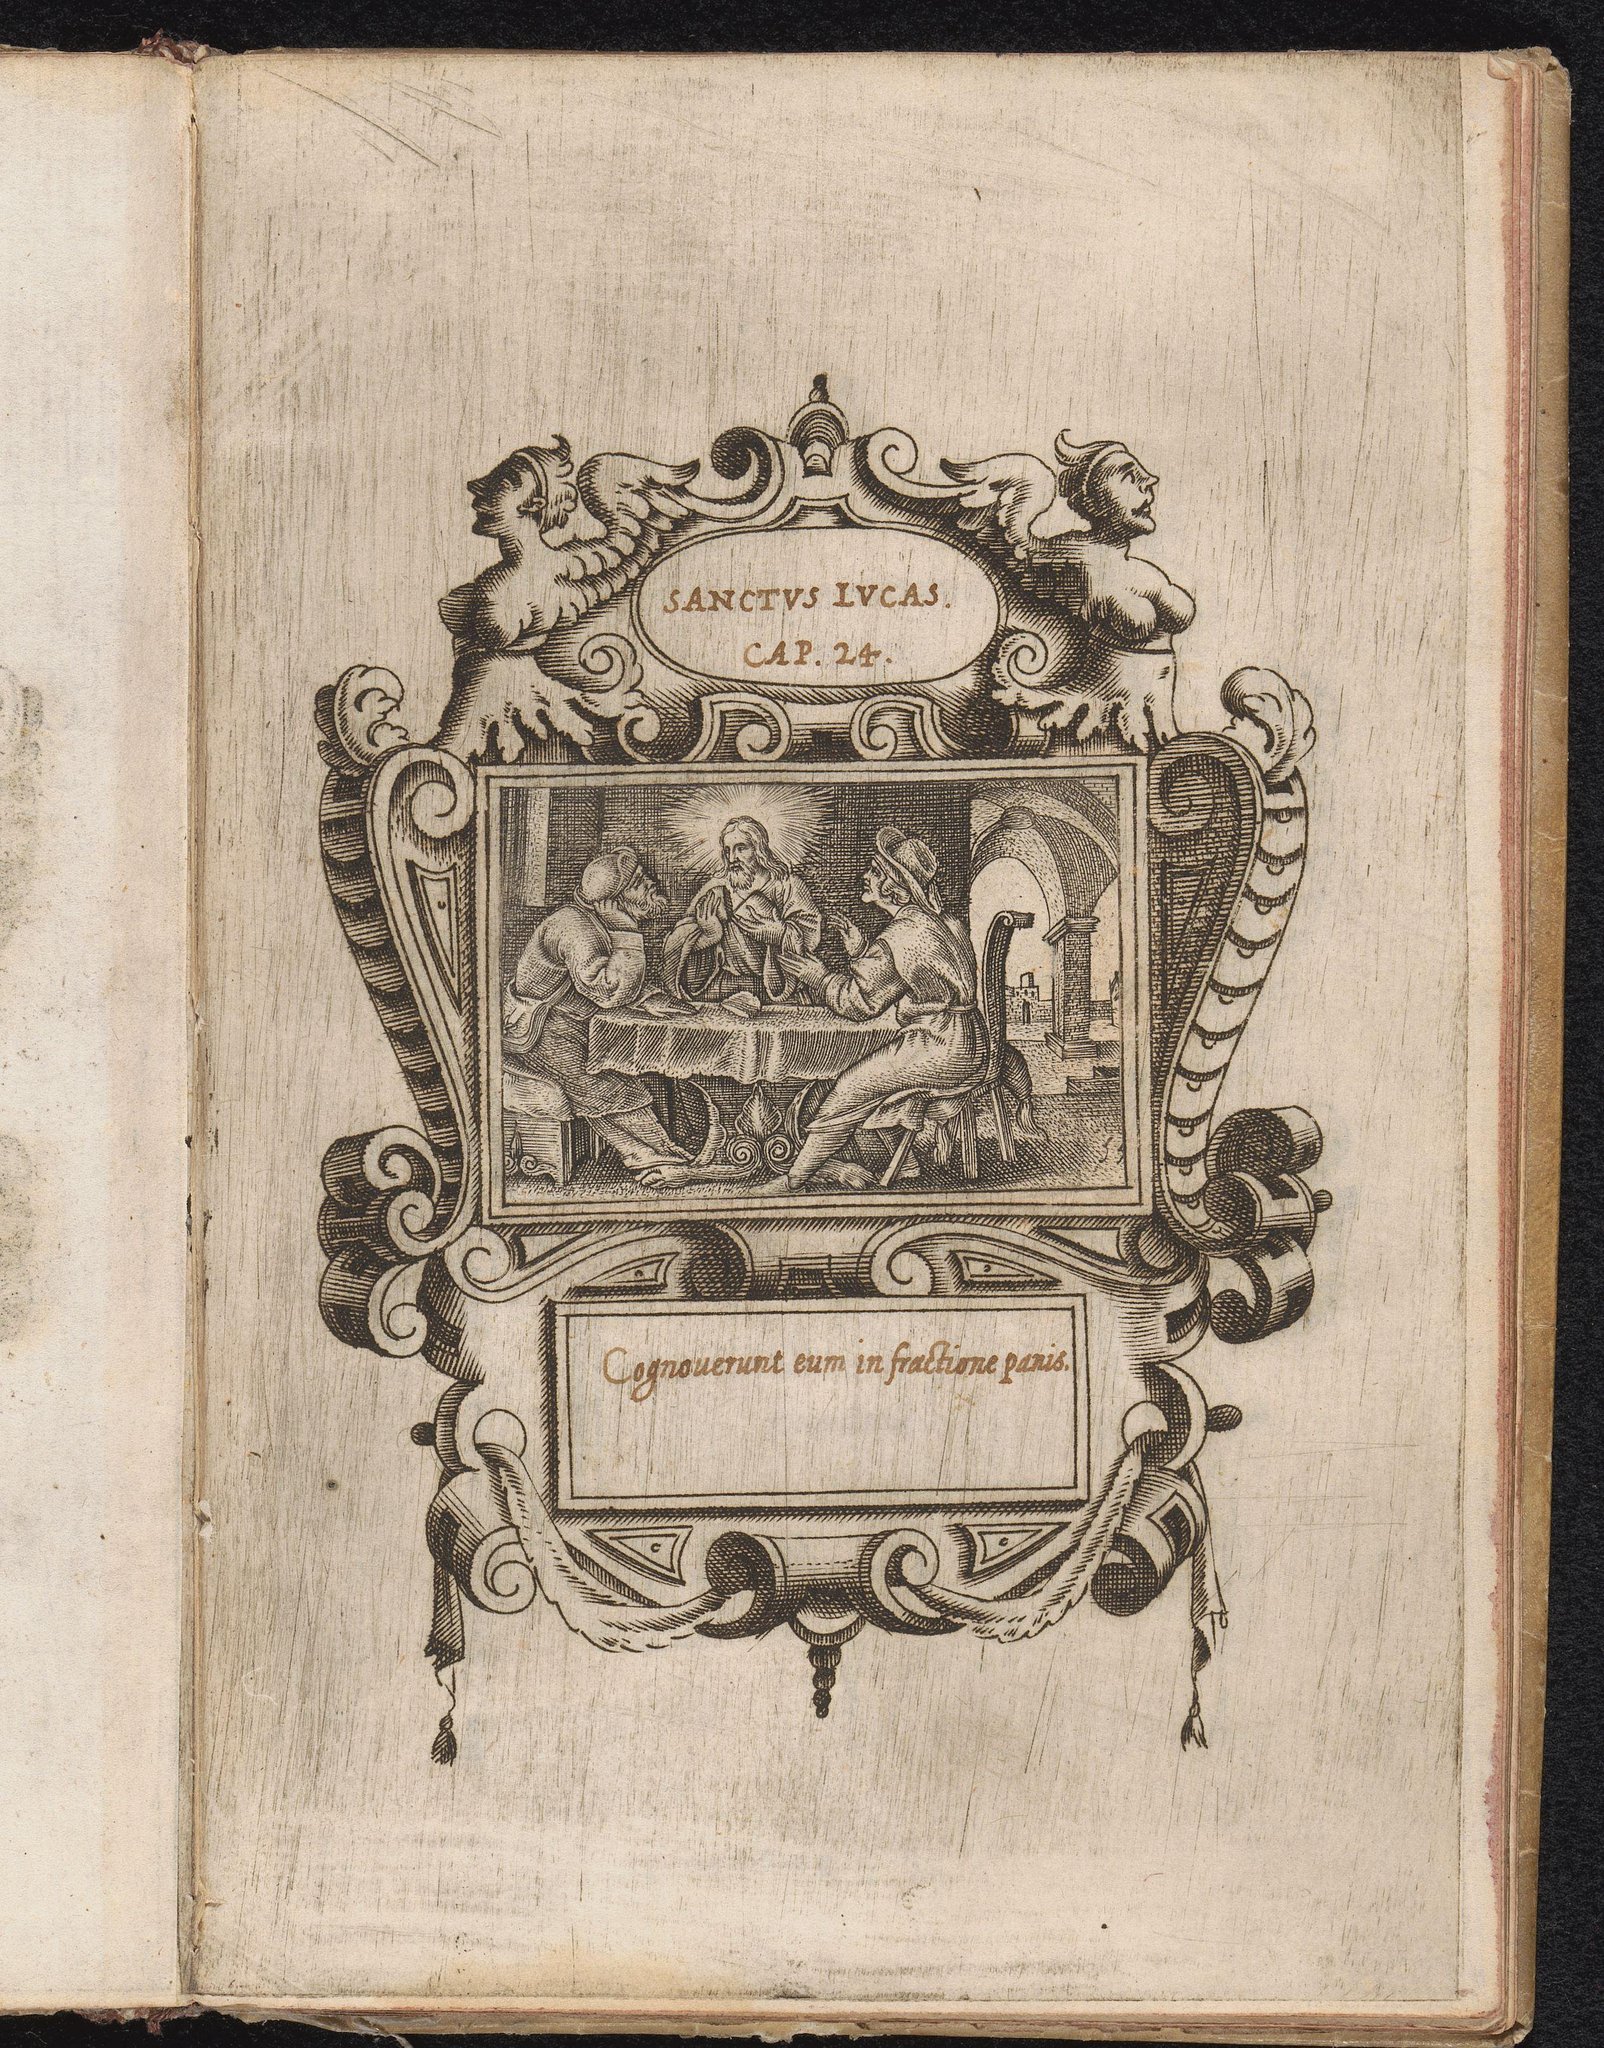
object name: print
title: Het leven van Christus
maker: Anonymous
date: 1570-1610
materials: paper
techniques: engraving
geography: germany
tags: the supper at emmaus: christ is recognized while blessing or breaking the bread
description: Maaltijd in Emmaüs. Onderdeel van een prentalbum met titelprent en 56 scènes uit het Nieuwe Testament. Elke voorstelling gemonteerd in een gravure met ornamentele cartouches waarin een venster is gesneden en voorzien van handgeschreven bijbelpassages.